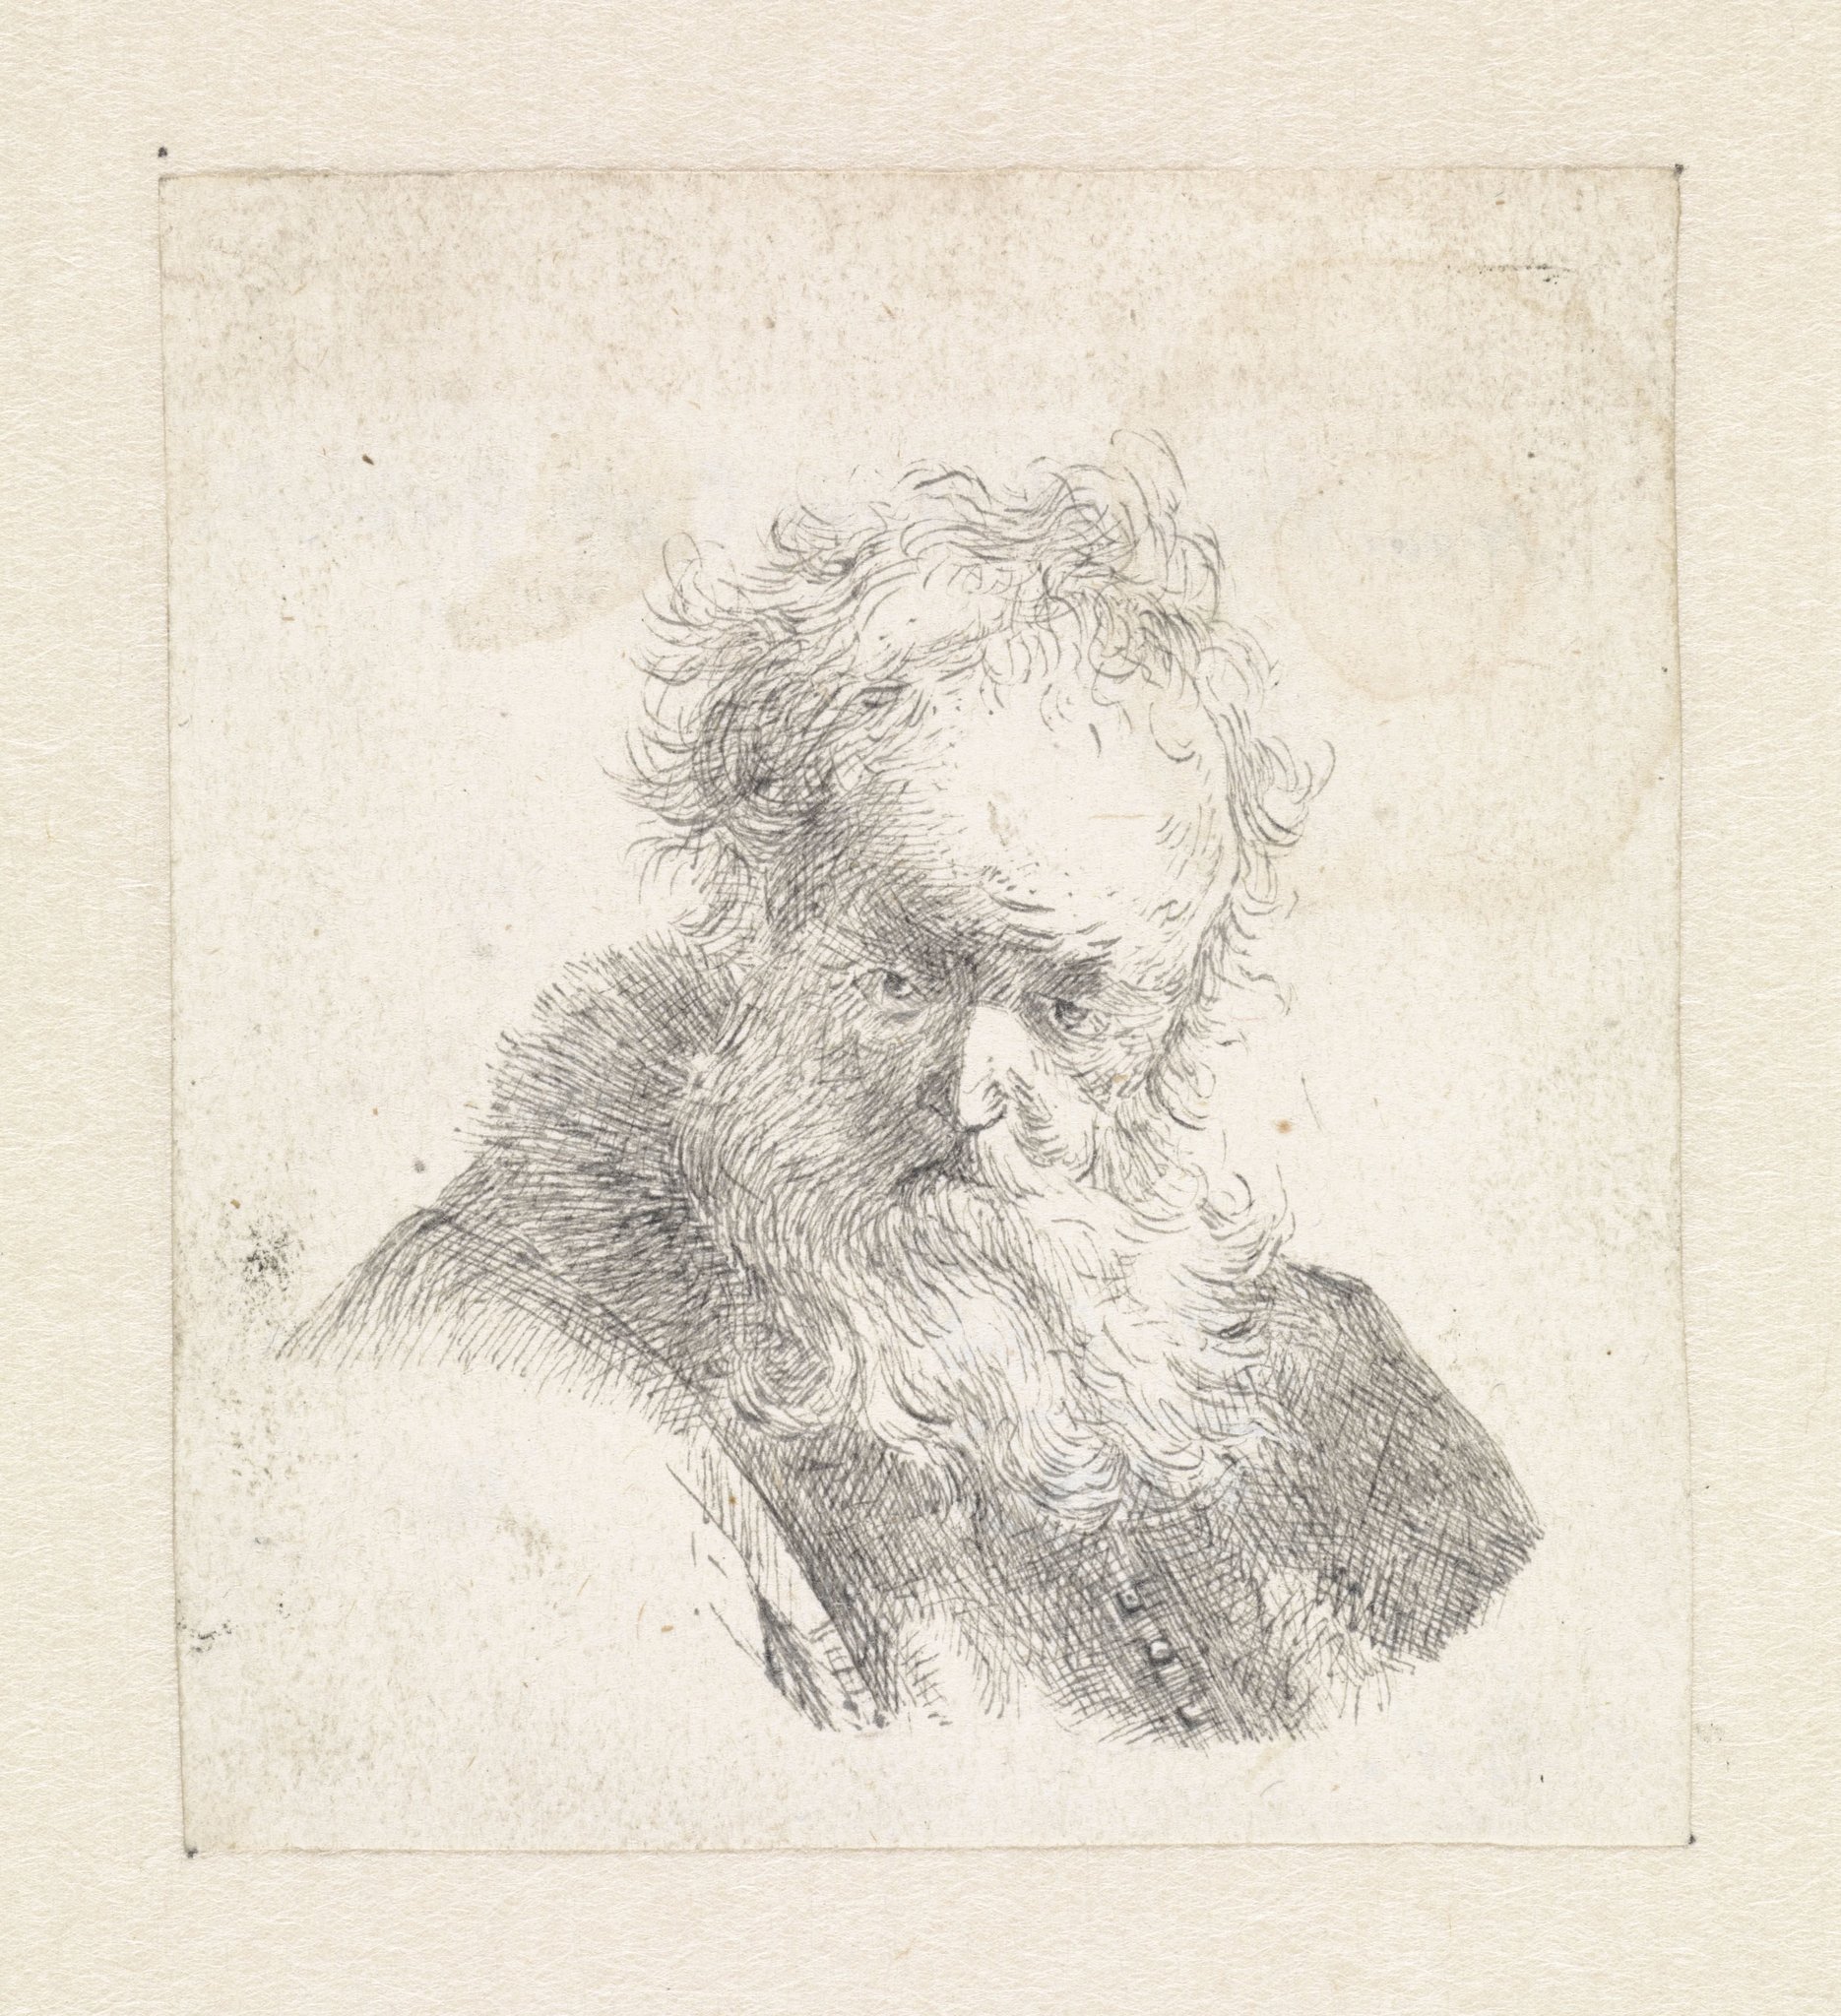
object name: drawing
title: Kop van een oude man met baard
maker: cornelis van der griendt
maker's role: draughtsman, painter, print maker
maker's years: 1827-1918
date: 1837-1918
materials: ink, paper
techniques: pen